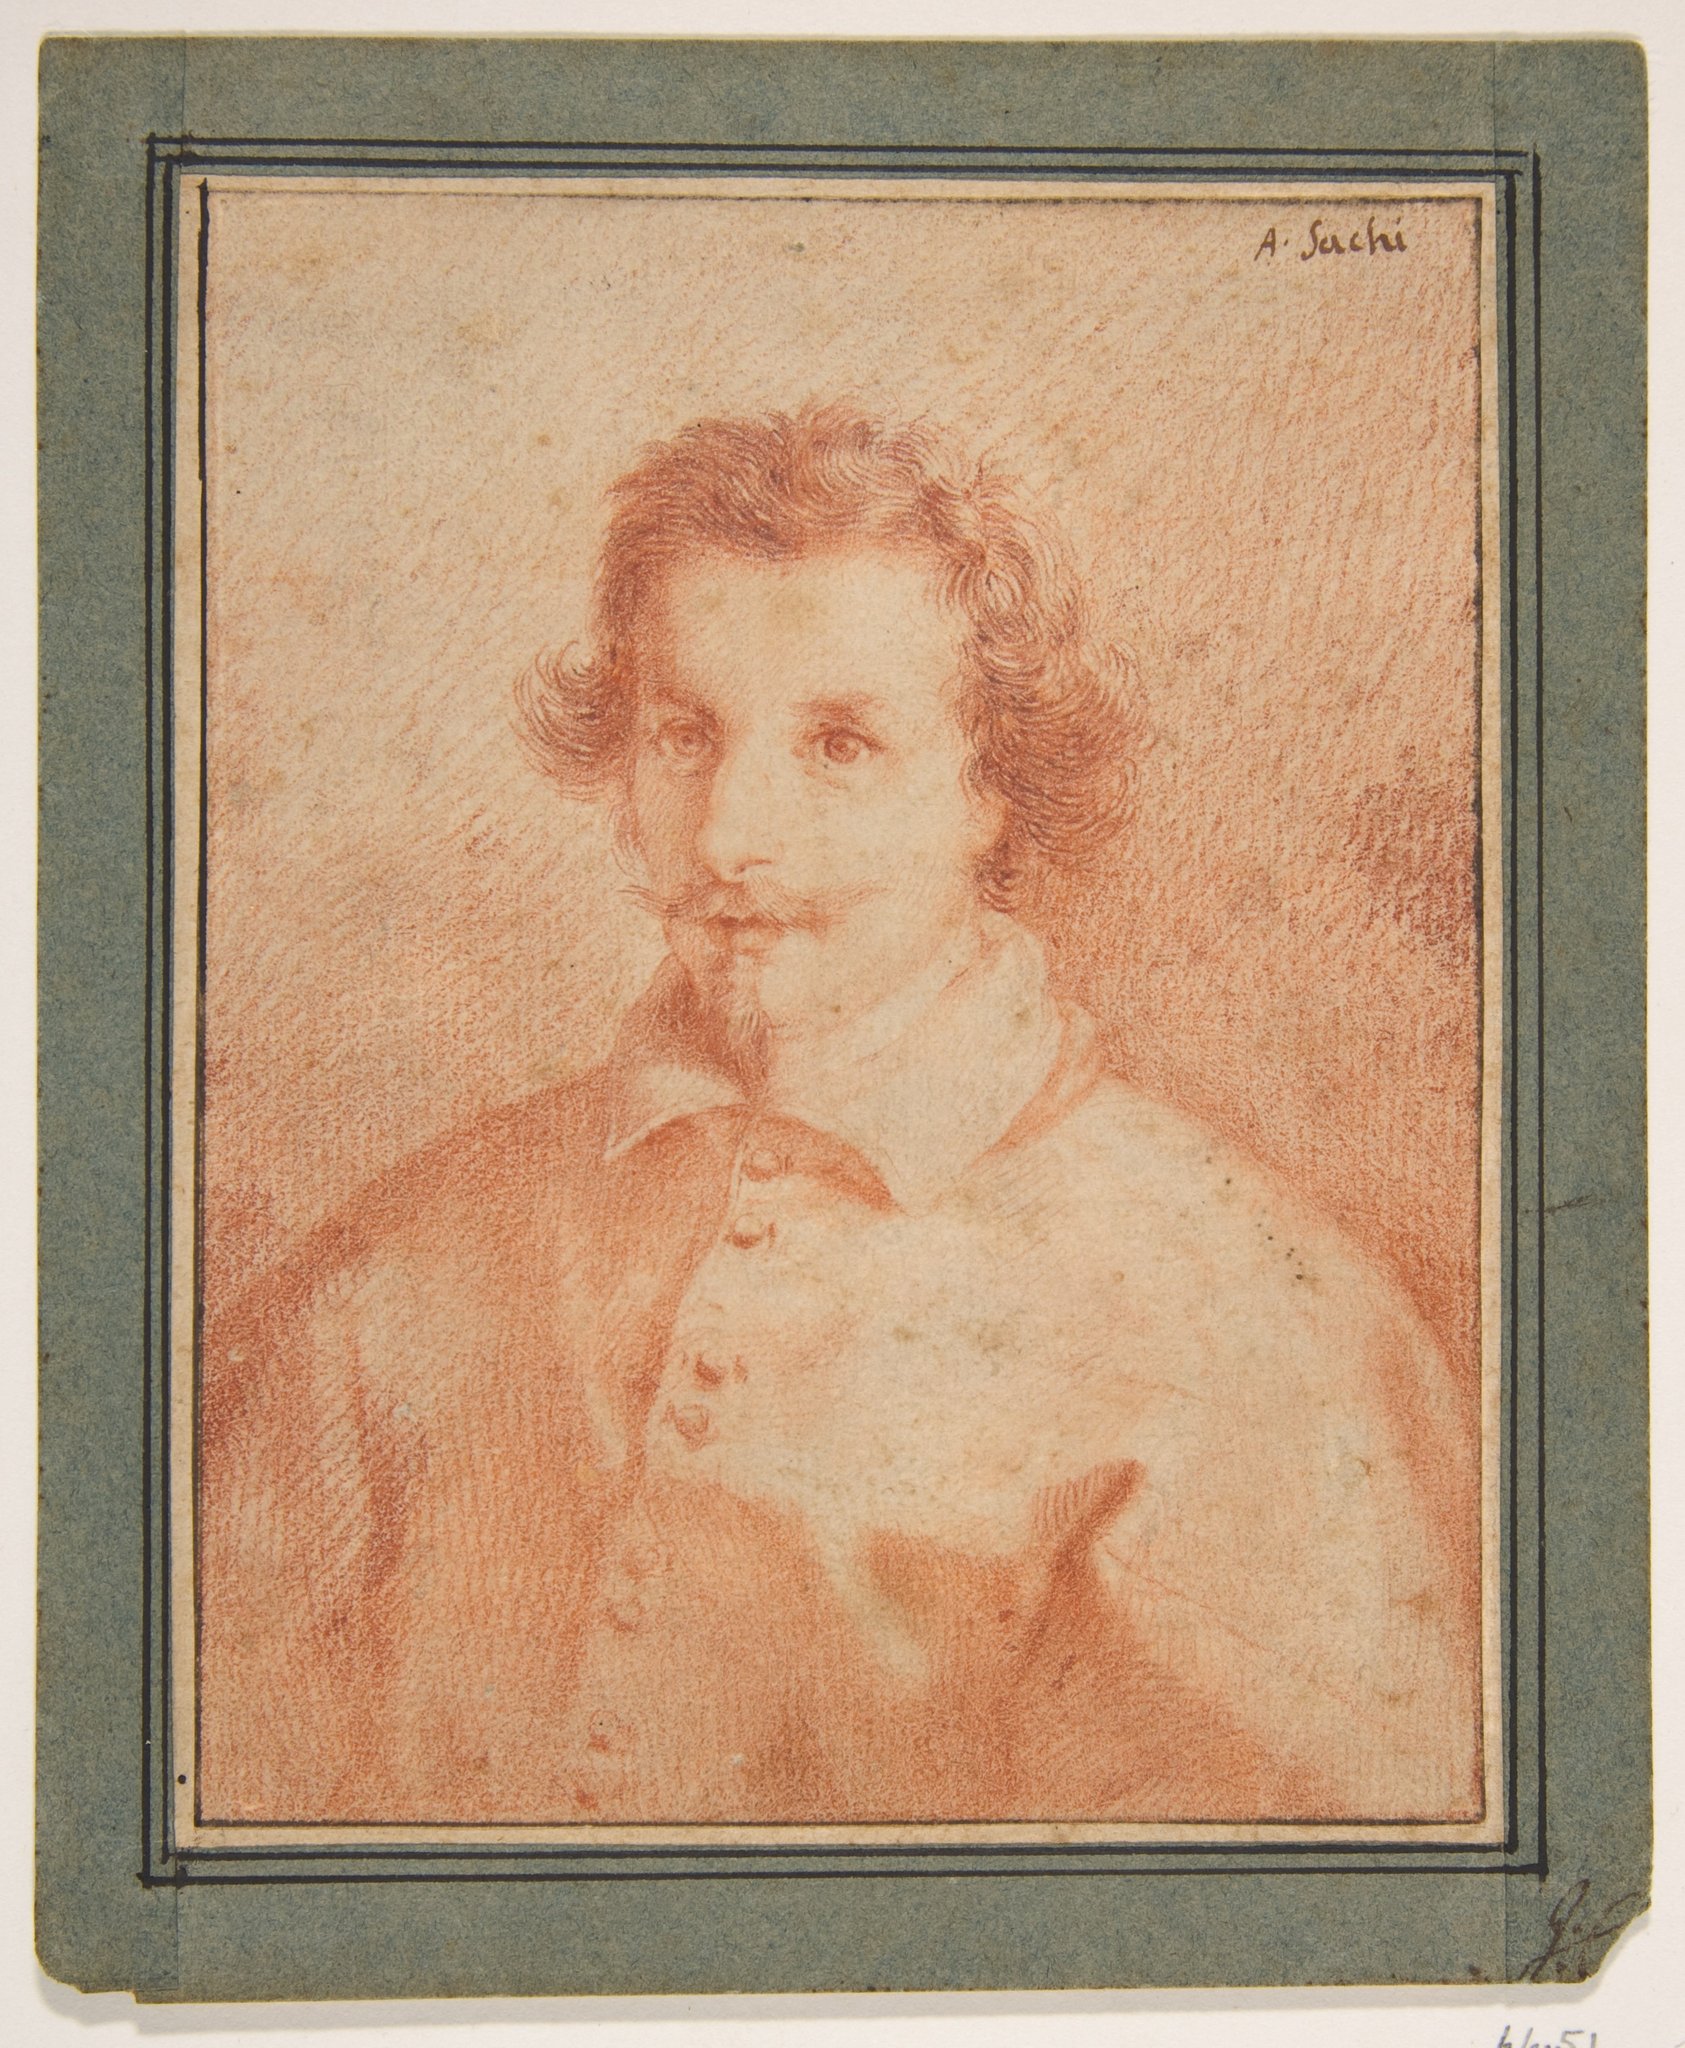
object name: drawing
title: Portrait of Cardinal Antonio Barberini the Younger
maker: andrea sacchi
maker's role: artist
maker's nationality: italian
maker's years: 1599-1661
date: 1599-1661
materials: chalk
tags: men,portraits